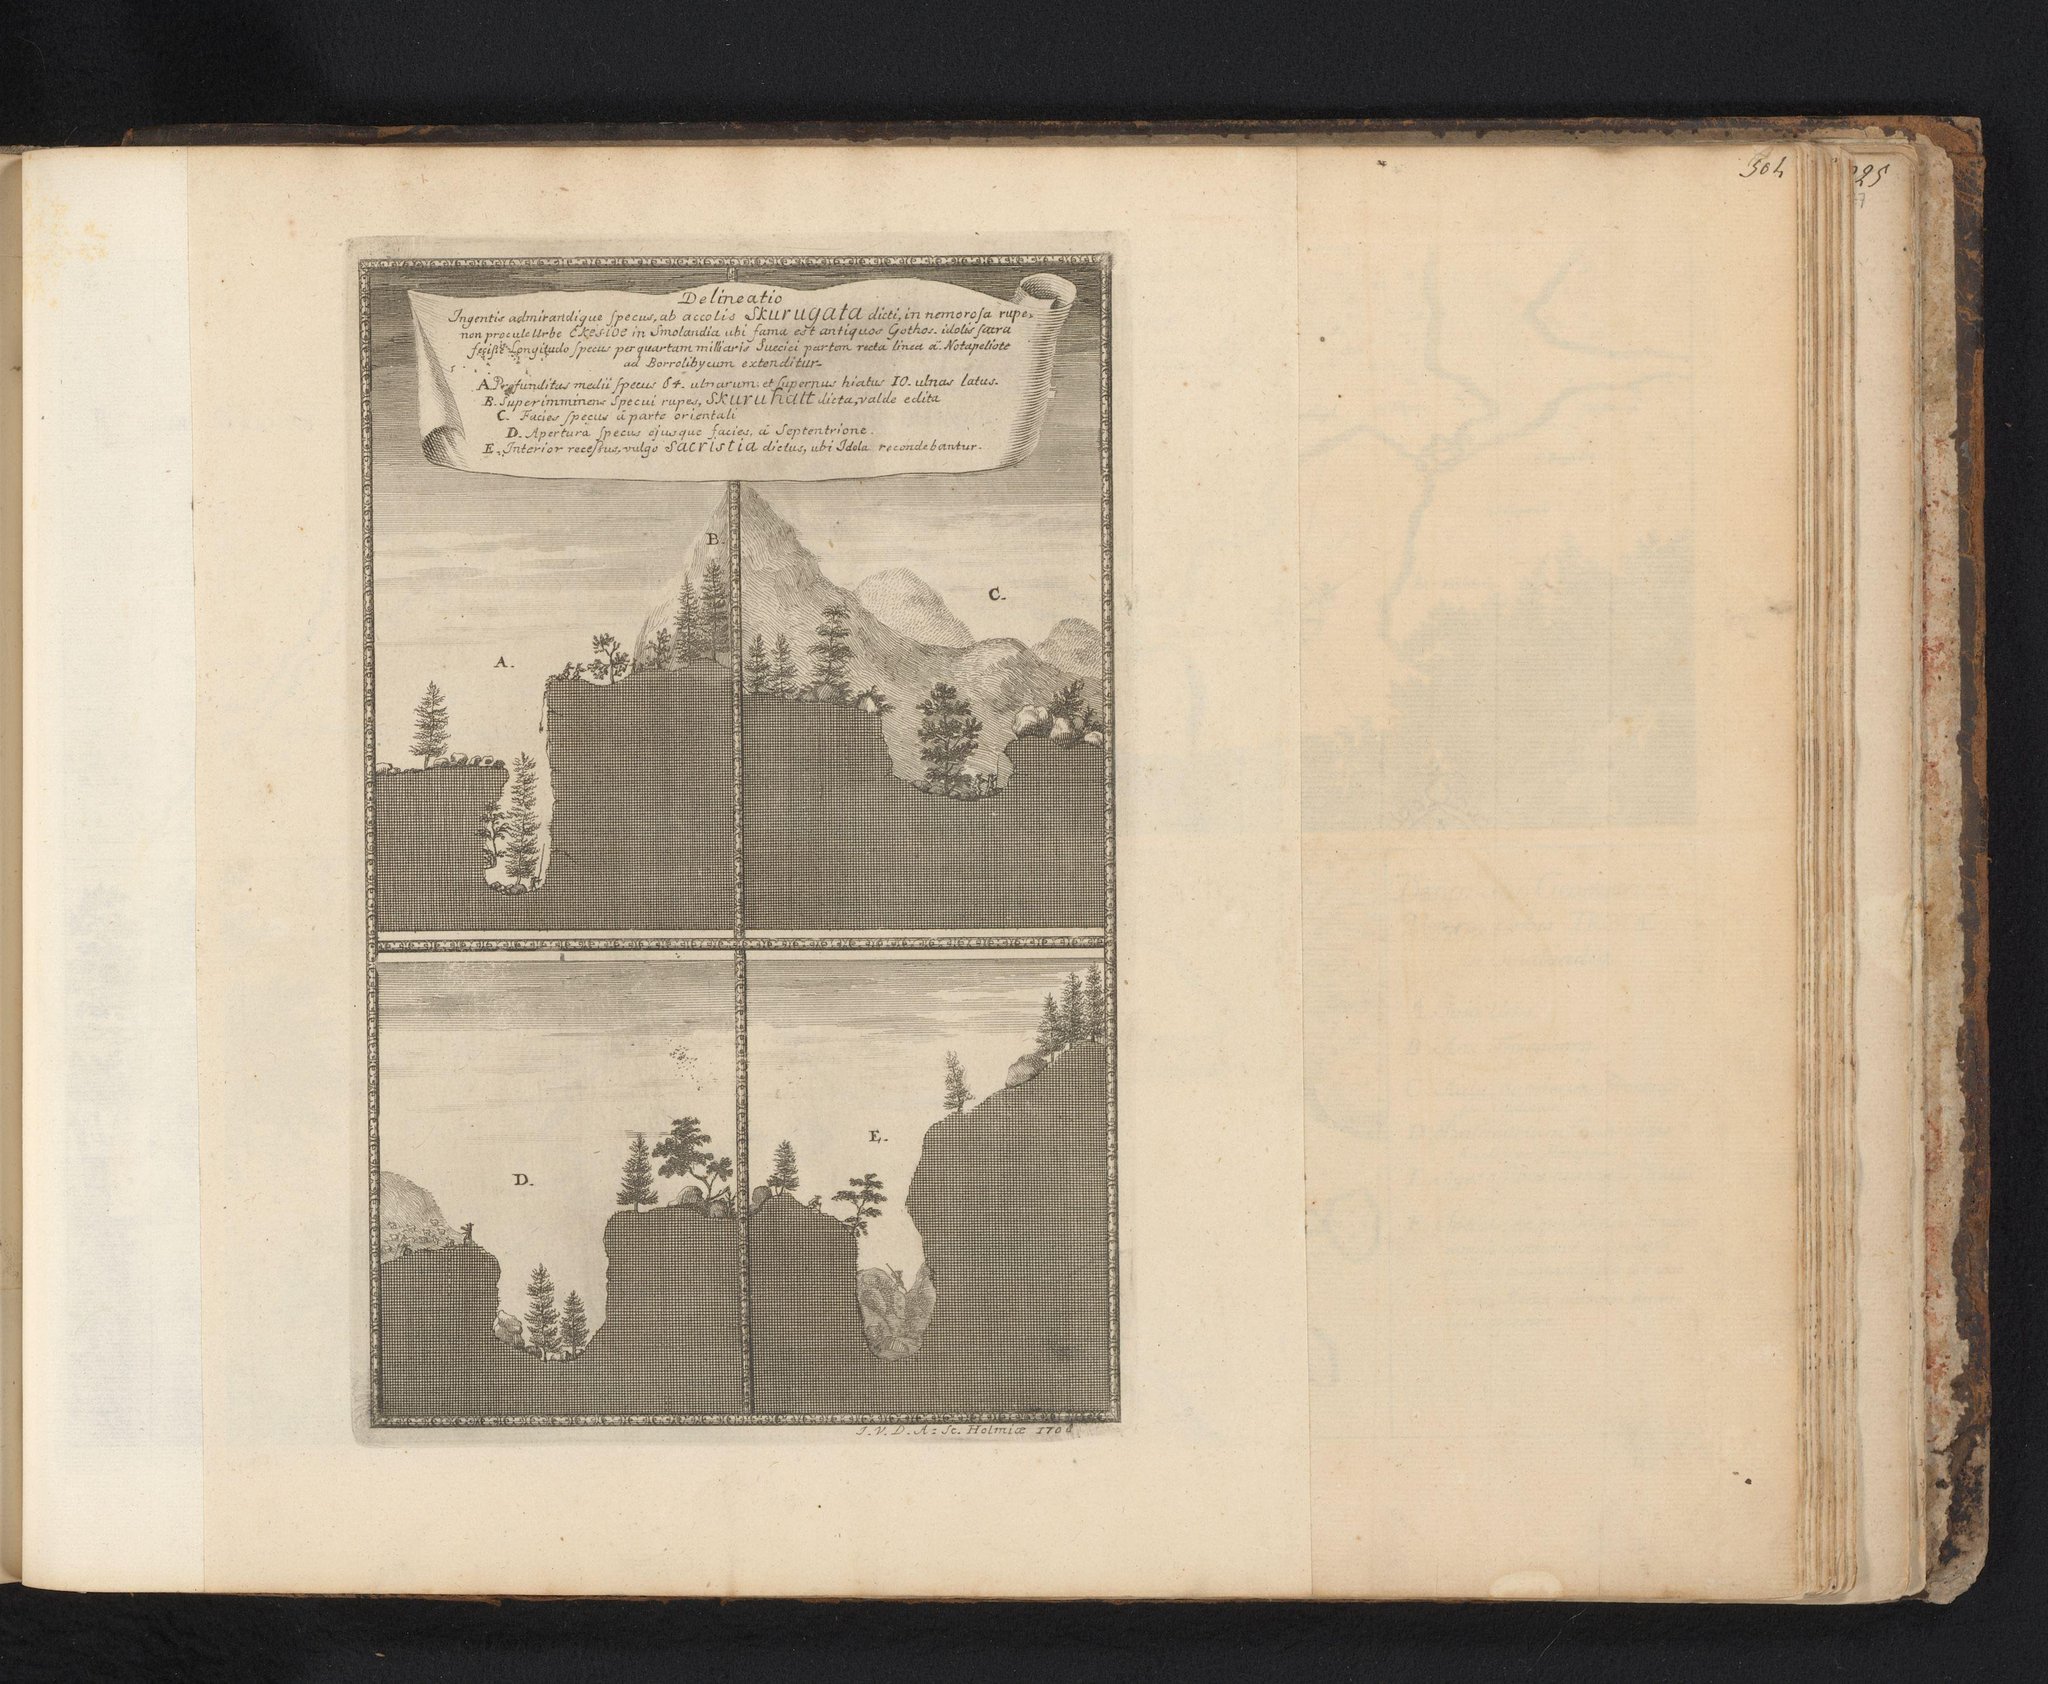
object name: album leaf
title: Suecia Antiqua et Hodierna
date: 1708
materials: paper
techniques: etching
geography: stockholm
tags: ravine, chasm, abyss, canyon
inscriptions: date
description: Kungliga Biblioteket, 'Suecia': http://www.kb.se/samlingarna/Kartor-bilder/Suecia-antiqua/ (geraadpleegd november 2016).